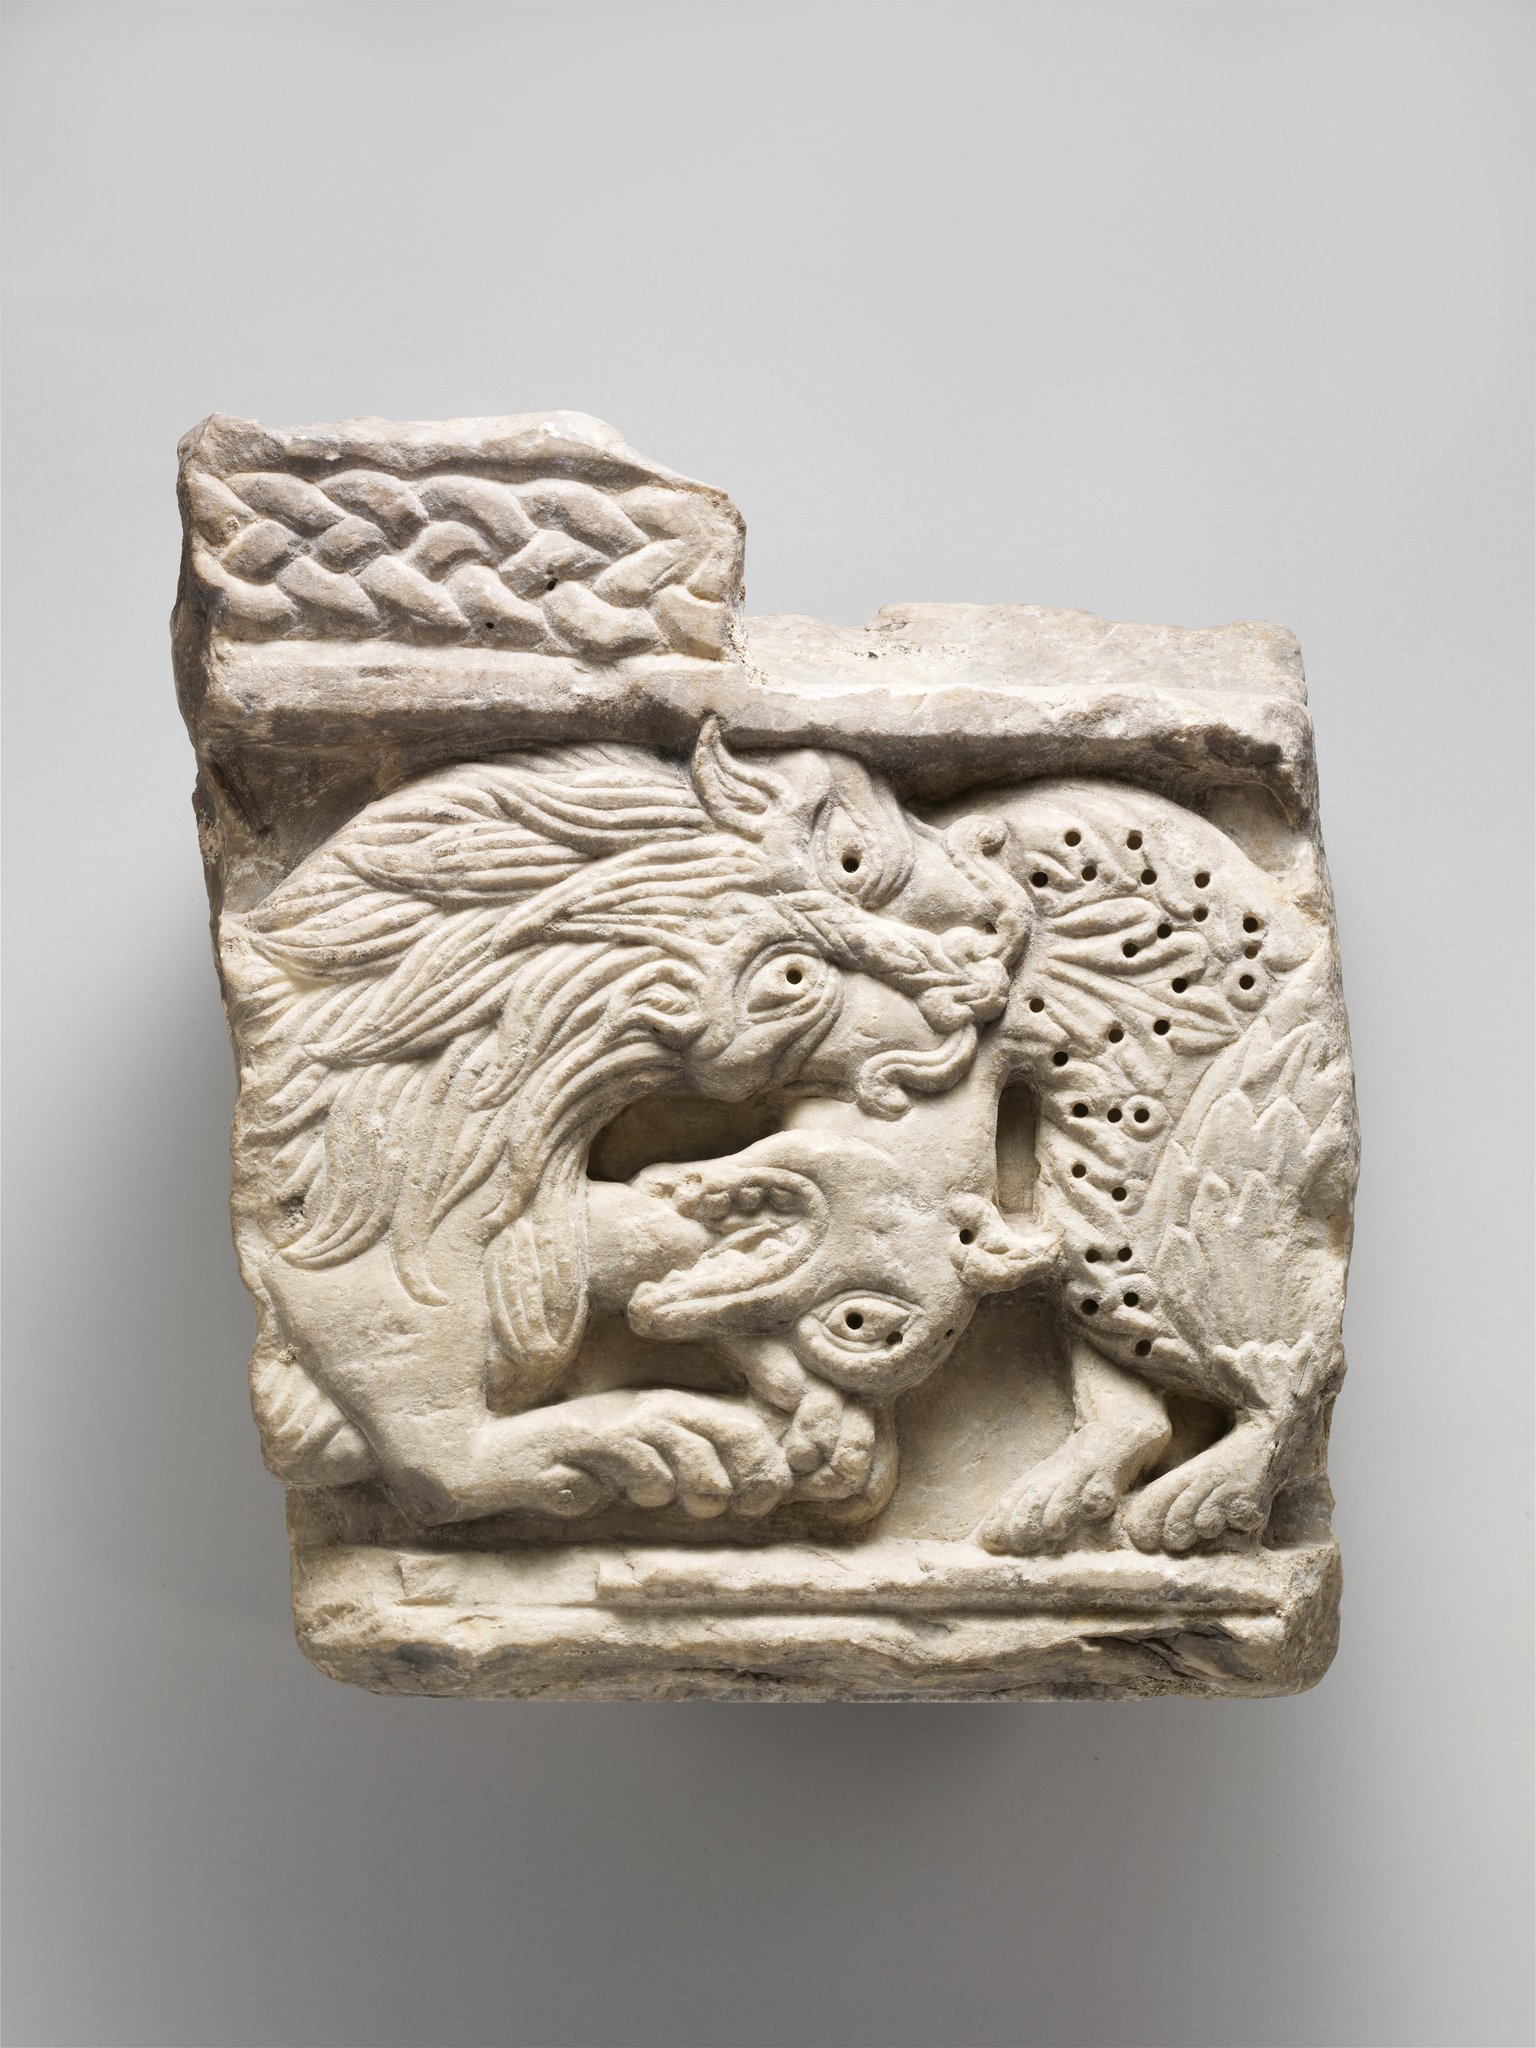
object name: relief fragment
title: Fragment of an Animal Relief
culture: italian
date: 1150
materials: marble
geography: italy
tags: animals